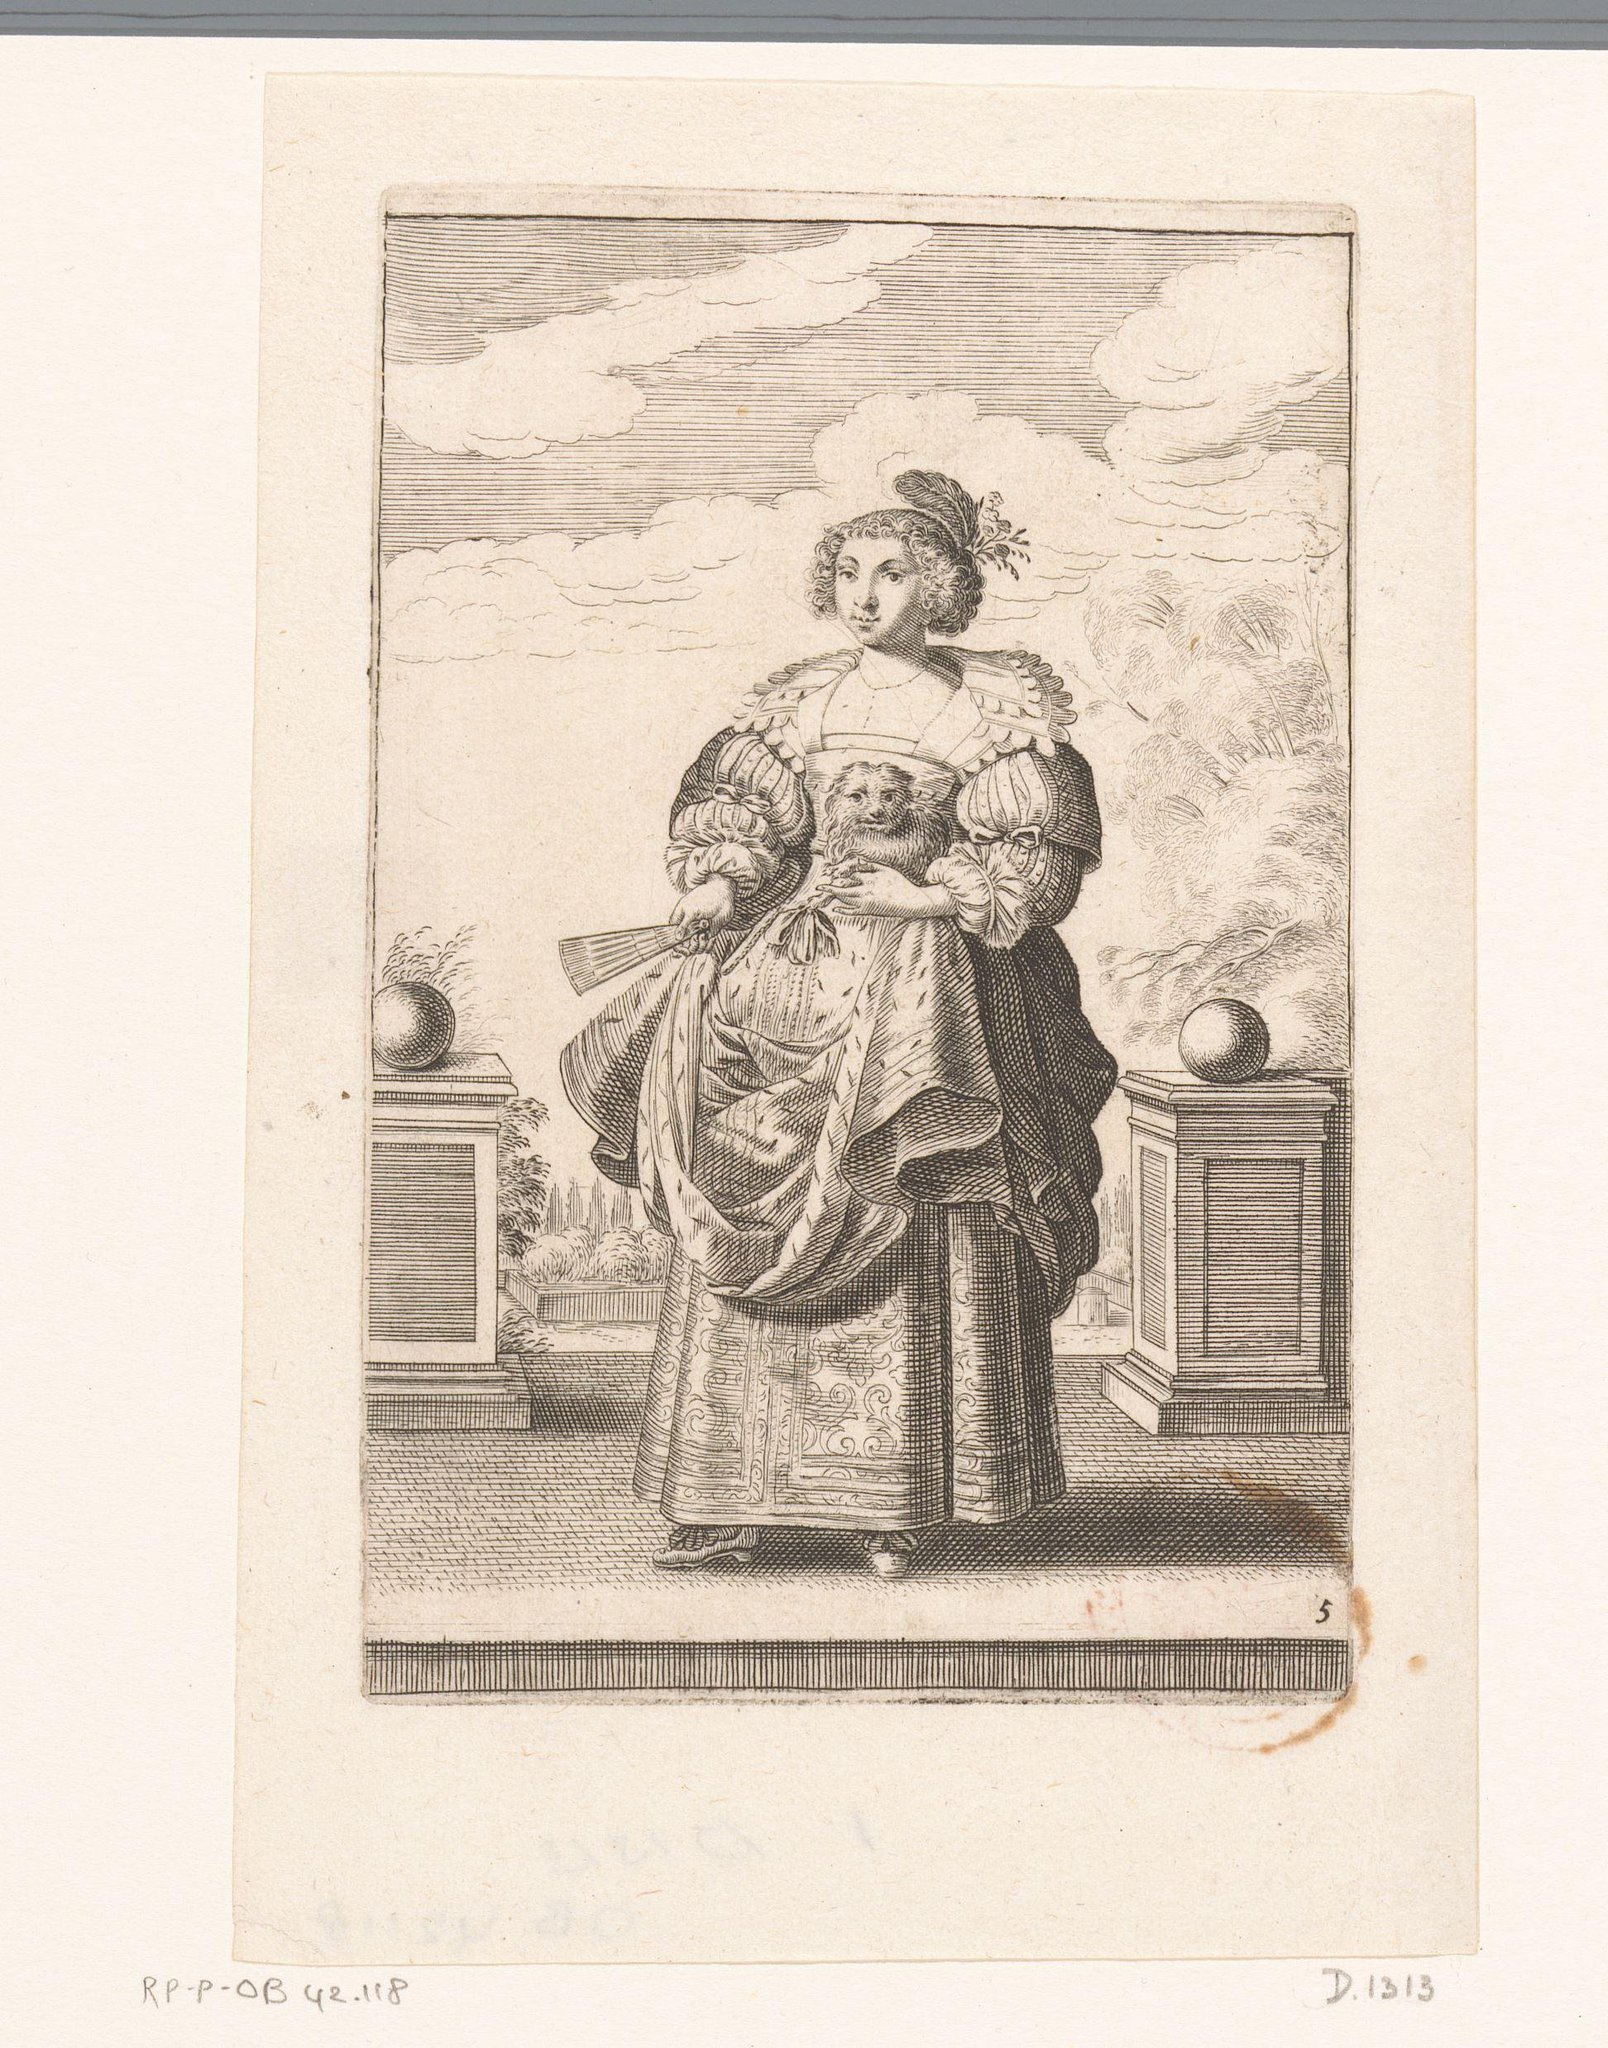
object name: costume print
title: Kostuums van de Franse adel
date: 1629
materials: paper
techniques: engraving, etching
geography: paris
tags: skirt (underskirt) (+ women's clothes), styles of hairdress - aa - ~ women, neck-gear: collar (+ women's clothes), clothes, costume (+ women's clothes), skirt (+ women's clothes), neck-gear: collar (+ lace used for clothes), dress, gown (+ women's clothes), europeans (with name), fan (+ women's clothes), sleeves (+ women's clothes), dog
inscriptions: collector's mark: Lugt 240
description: Ihle p. 30, nr. 80: Vergeleken met de jonge adellijke dames van Callot (ca. 1625) is er in die paar jaar (deze serie is van 1629) heel wat in de mode veranderd. We hebben hier ws. met de kostuums uit Parijs te maken die de laatste modeveranderingen laten zien. Het kroezige haar met pony, de lage vierkante hals, die in Frankrijk liefst onbedekt blijft, de hoge taille en de ballonvormige mouwen wijzen alle op de veranderingen die zich in deze periode voltrokken.